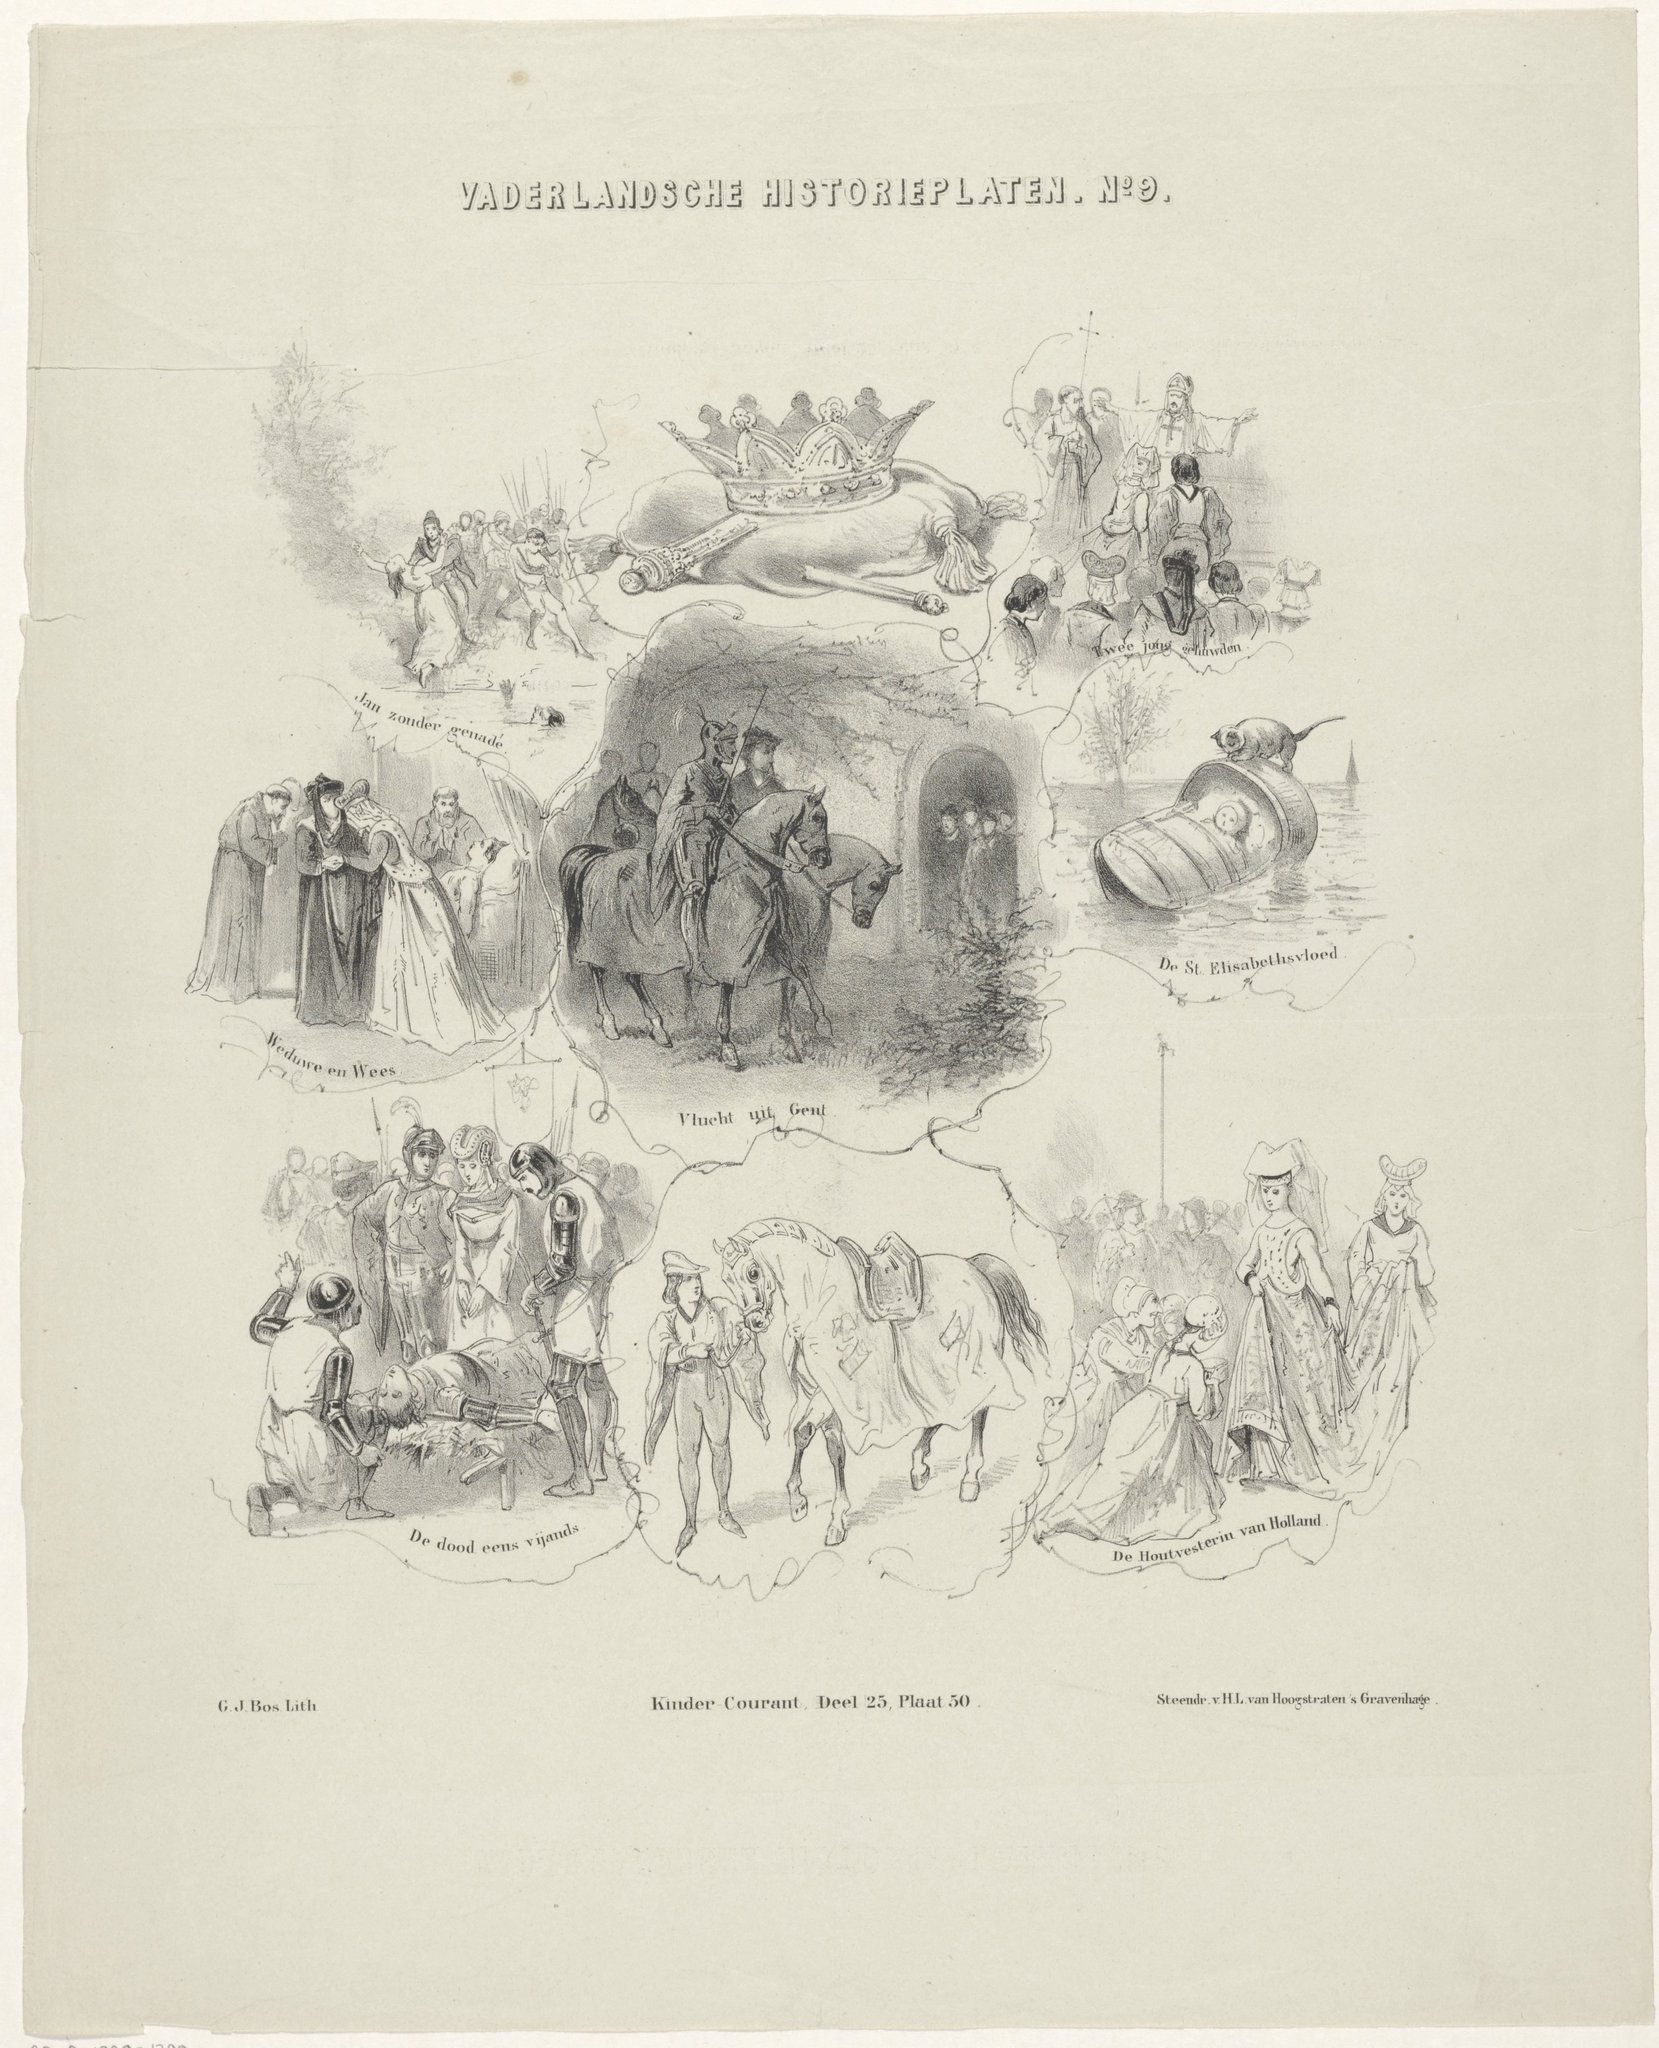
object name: kinderprent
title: Vaderlandsche historieplaten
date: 1859-1896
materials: paper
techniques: lithograph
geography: netherlands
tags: jan van beieren, (carrying a person on a) litter, stretcher, flood, widow, leading a horse by the reins; rider beside his horse, orphans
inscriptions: collector's mark: Lugt 2228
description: Afgebeeld zijn verschillende scènes met daaronder een omschrijving. In het midden twee ruiters te paard bij een poort. Rechts daarvan een baby in een wieg, dobberent op een rivier met daar bovenop een kat. Links van het midden twee huilende vrouwen bij een overledene in bed. Linksonder een ridder gestorven op het slagveld. Rechts onderin de houtvestering van Holland. Midden onder begeleid een ruiter zijn paard aan de teugel. Linksboven een episode uit het leven van Jan van Beieren (Jan zonder Genade) en rechtsboven twee jonggehuwden. Deze prent werd uitgegeven bij de Kinder-Courant.